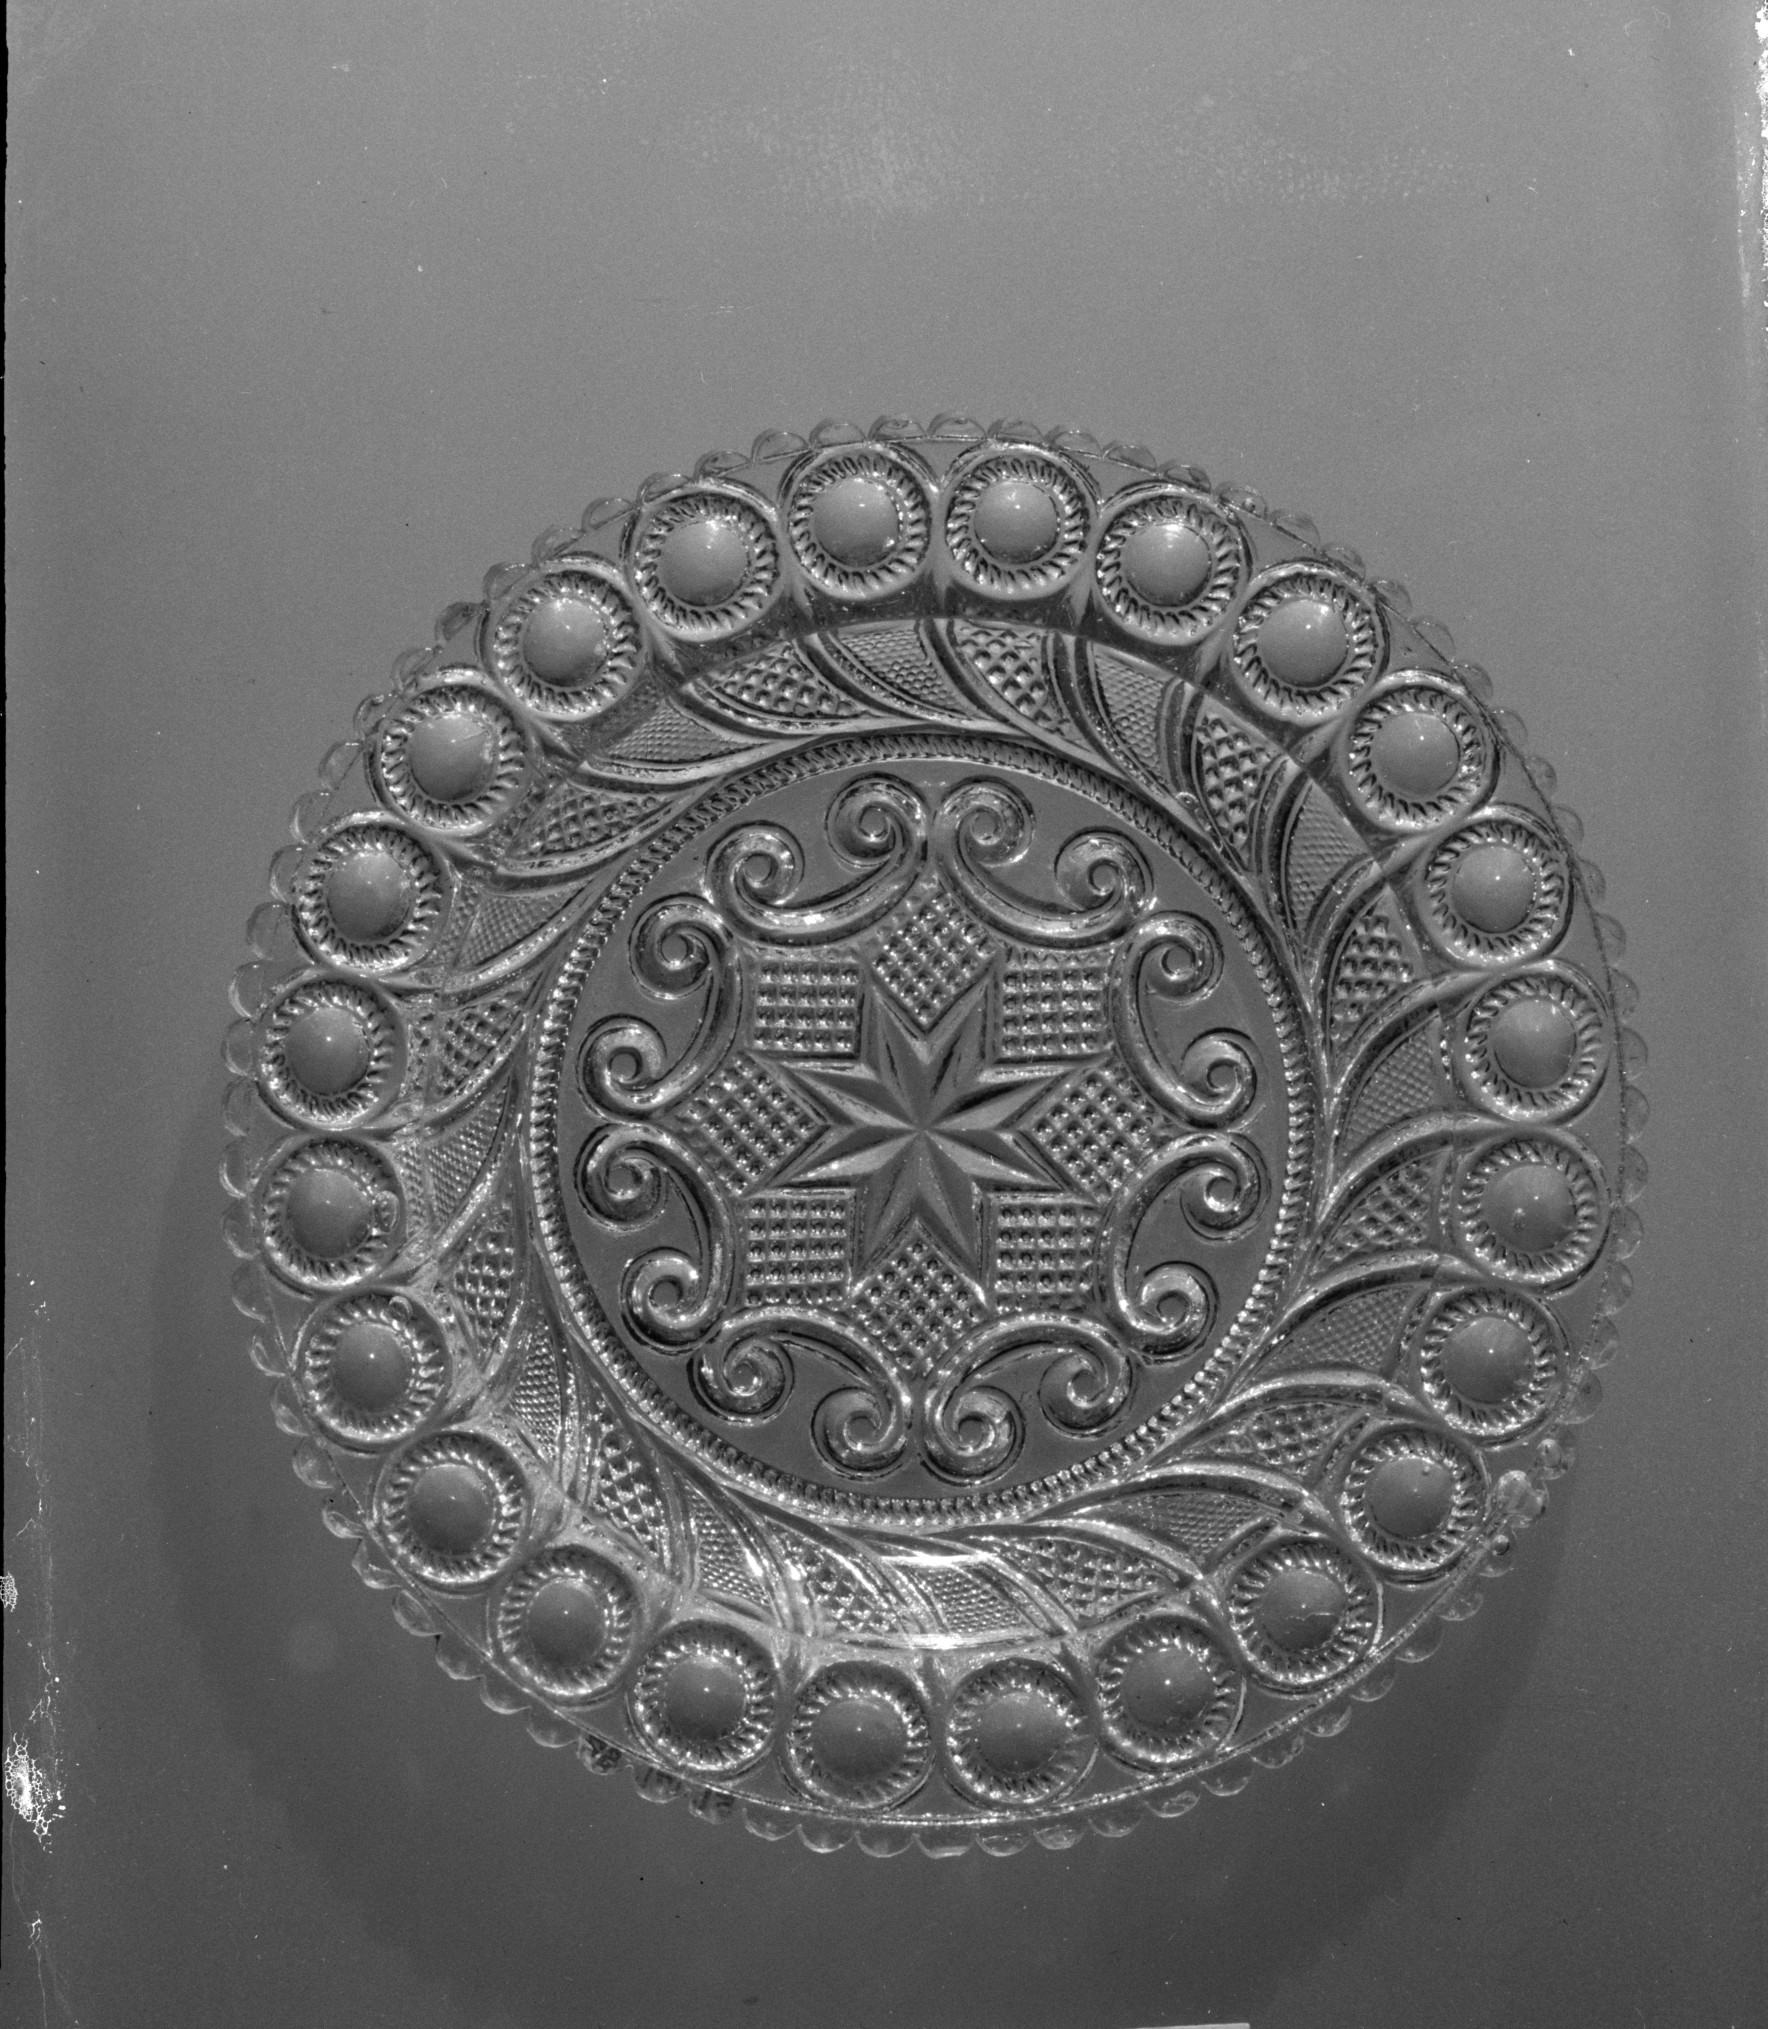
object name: plate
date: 1830-1845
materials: glass